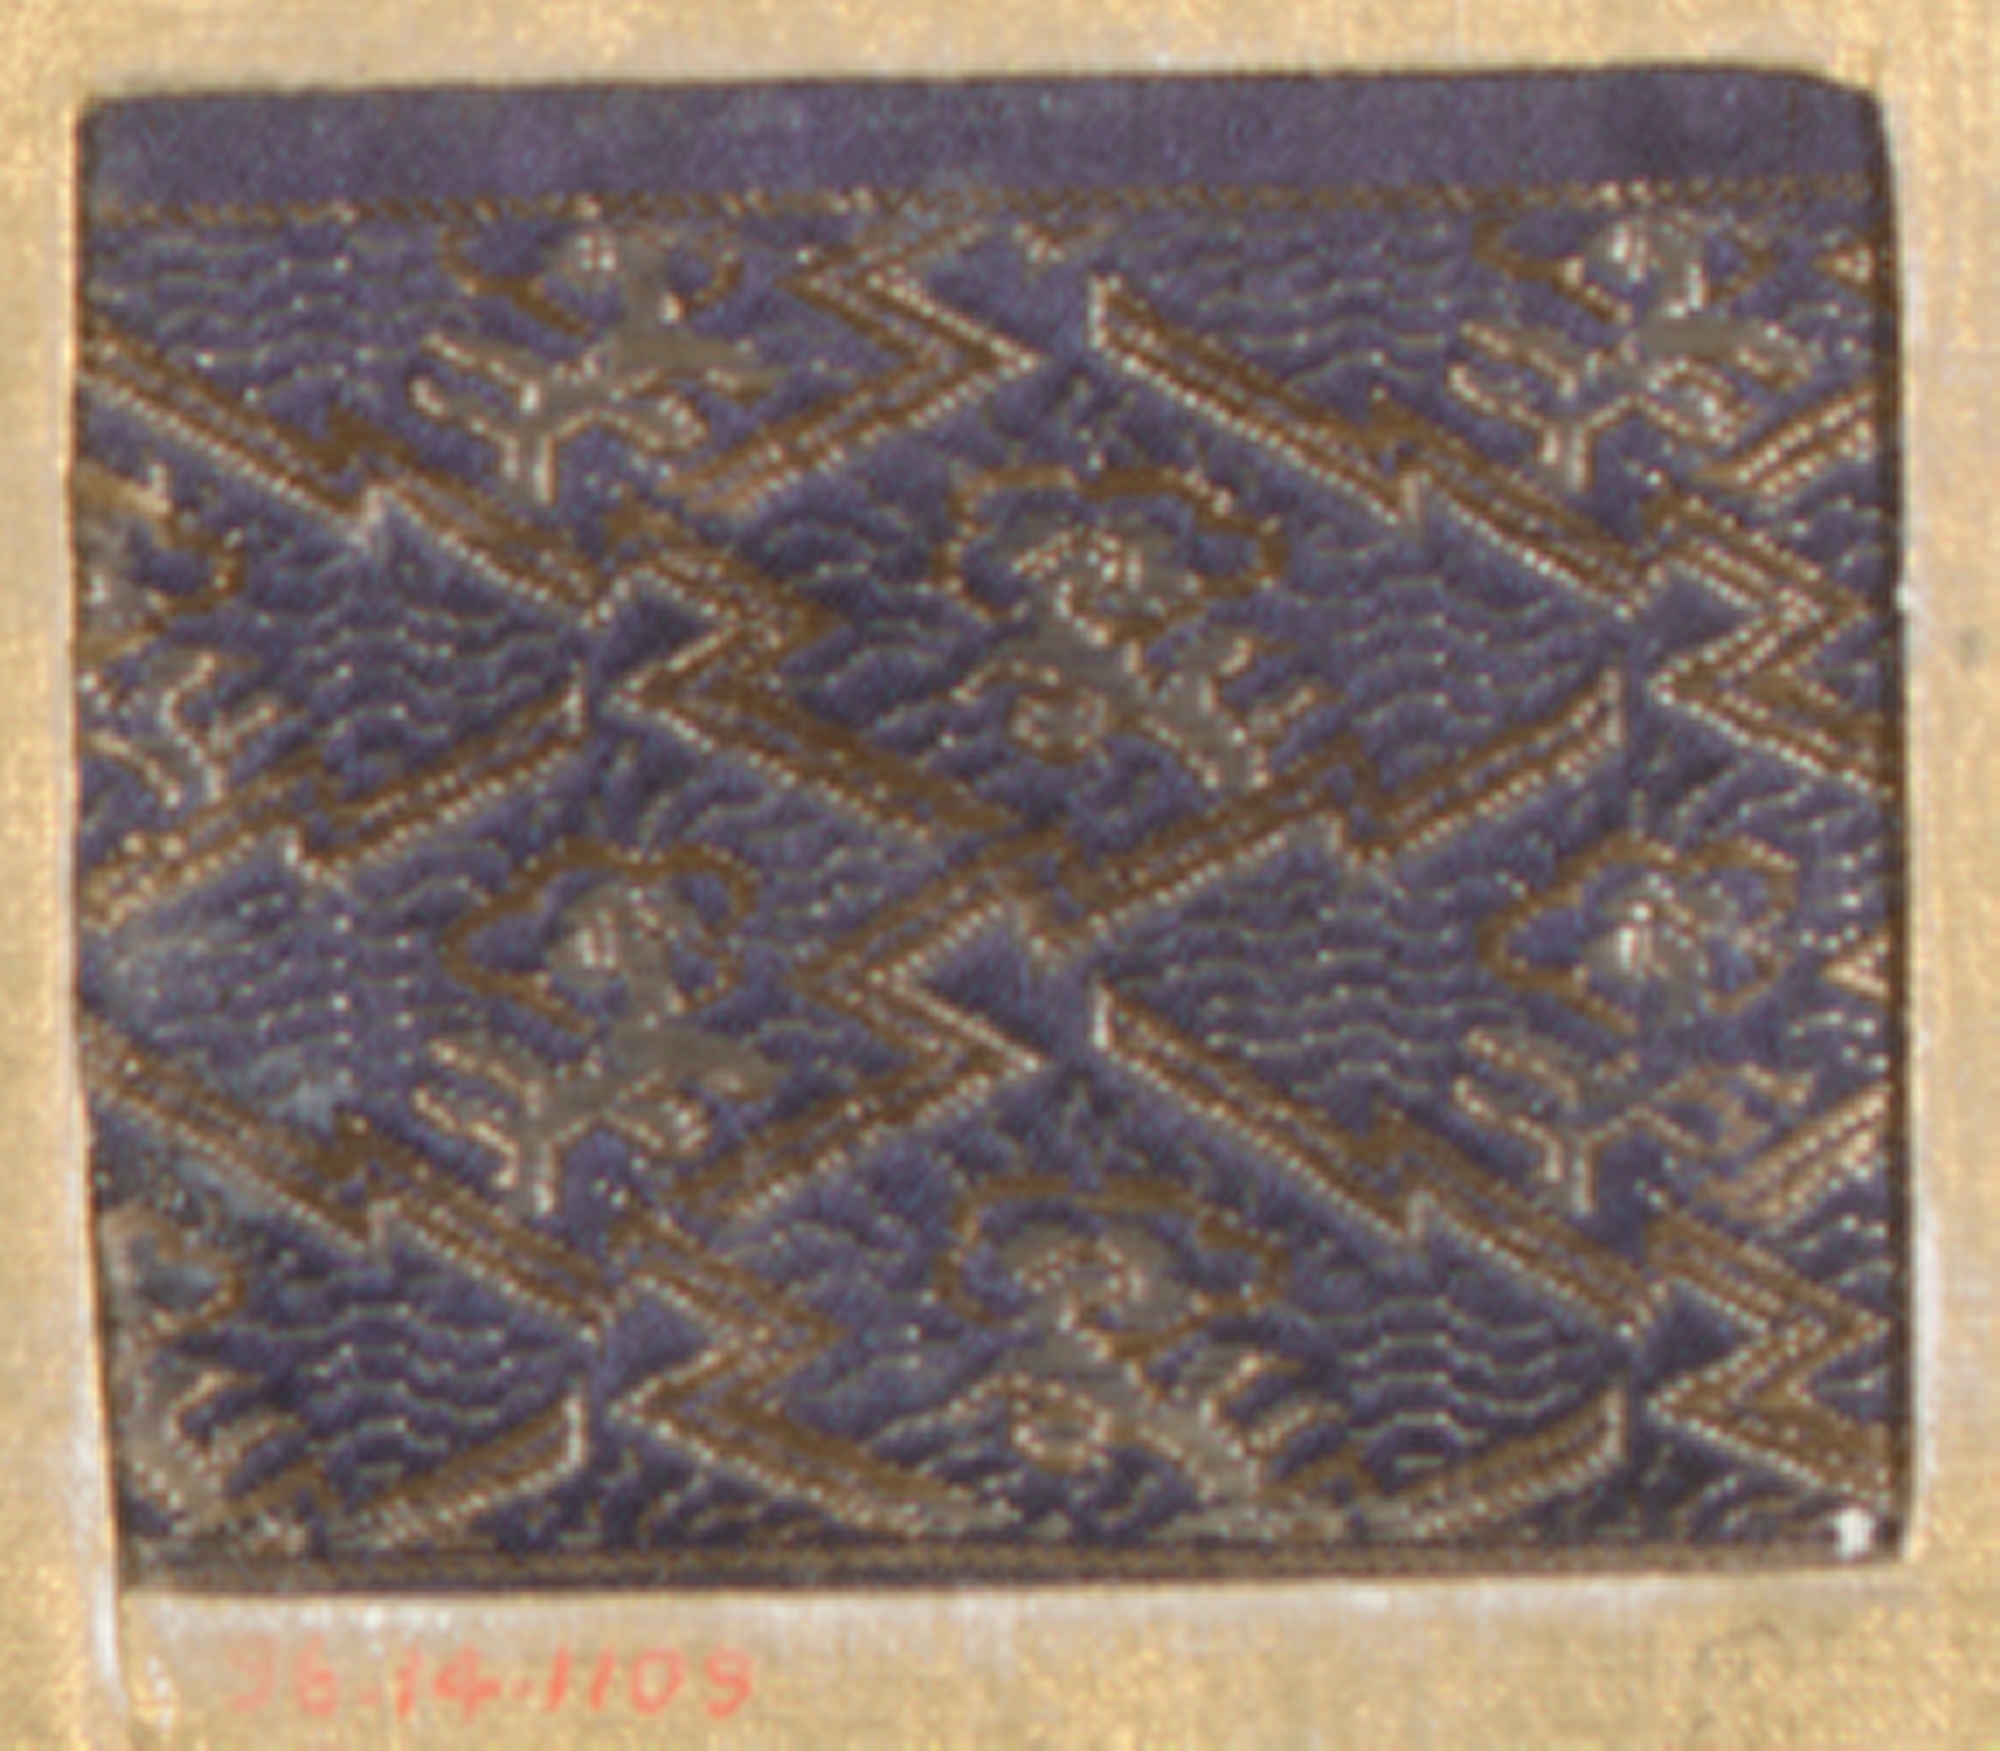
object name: piece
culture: japanese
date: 1701-1900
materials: silk